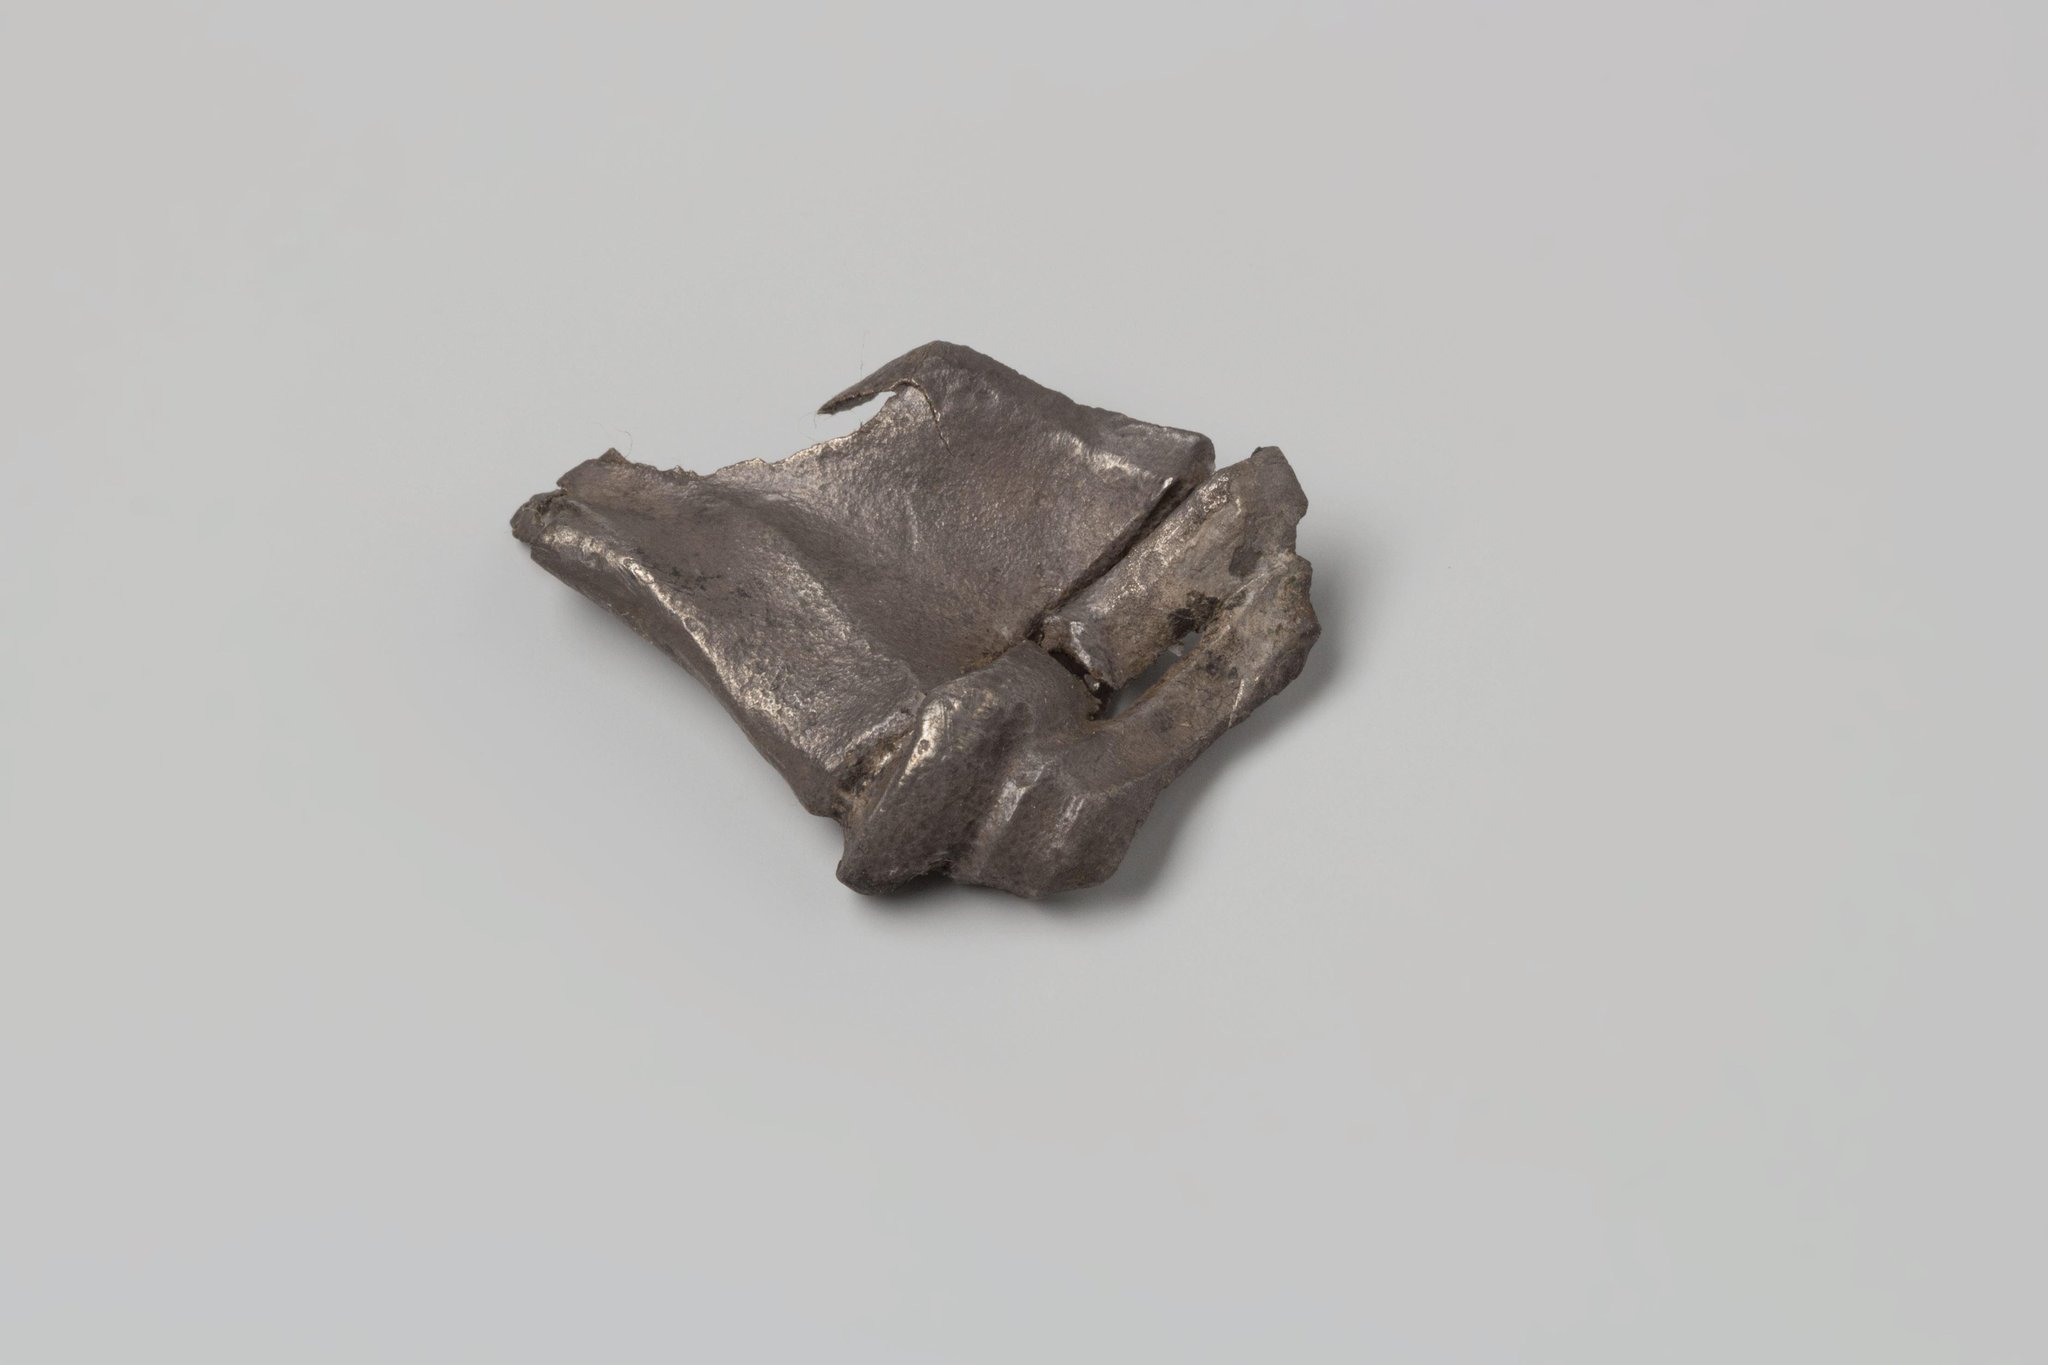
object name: candlestick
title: Fragment steel van een kandelaar uit het wrak van de Oost-Indiëvaarder Hollandia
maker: Anonymous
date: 1700-1743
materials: silver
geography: netherlands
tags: verenigde oostindische compagnie, hollandia (schip), annet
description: Candlestick, stem; fragm, squashed, originally faceted, moulded rim.